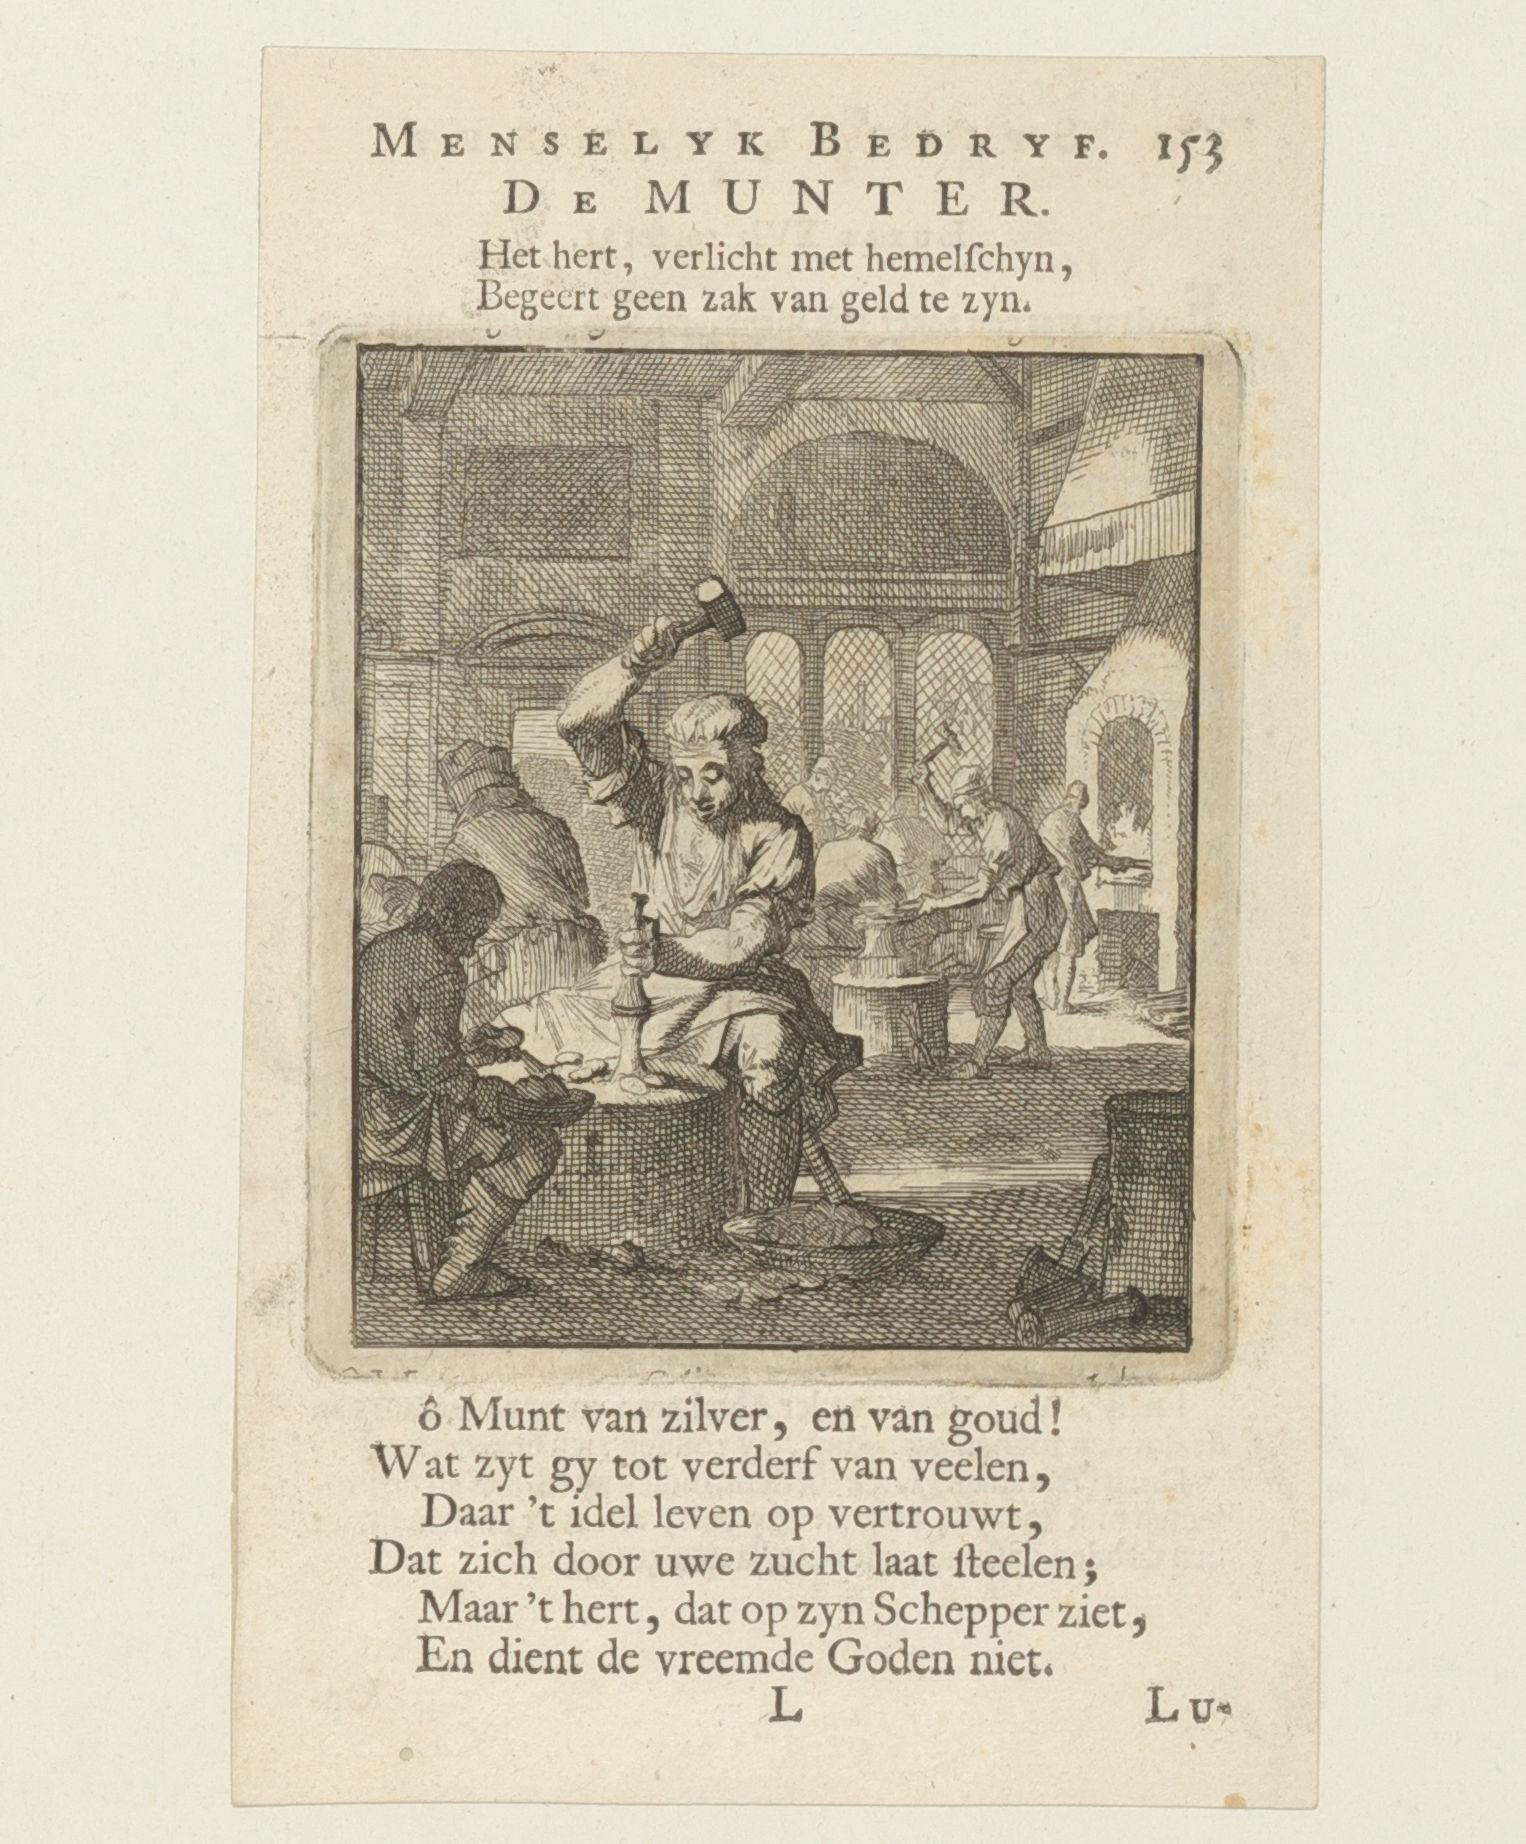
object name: print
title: Munter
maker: cornelis van der sys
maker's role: publisher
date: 1718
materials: paper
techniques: etching, letterpress printing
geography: amsterdam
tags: handicrafts, craftsman at work, minter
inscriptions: collector's mark: Lugt 1641, stamp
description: Prent oorspronkelijk verschenen in de 100-delige serie beroepsprenten van Jan en Caspar Luyken, getiteld: Het menselyk bedryf. S.l.s.n., 1694 (eerste druk). Daarna is de titel en het vers afgesneden. De prenten in diverse publicaties verschenen en gekopieerd. Huidige staat uit: Luyken, Jan en Caspar. Spiegel van het menselyk bedryf (...). Amsterdam: Cornelis van der Sys, 1718, p. 153. Prent waarschijnlijk ook gebruikt in eerdere (1704) en latere (1730, 1749, 1767) publicaties.